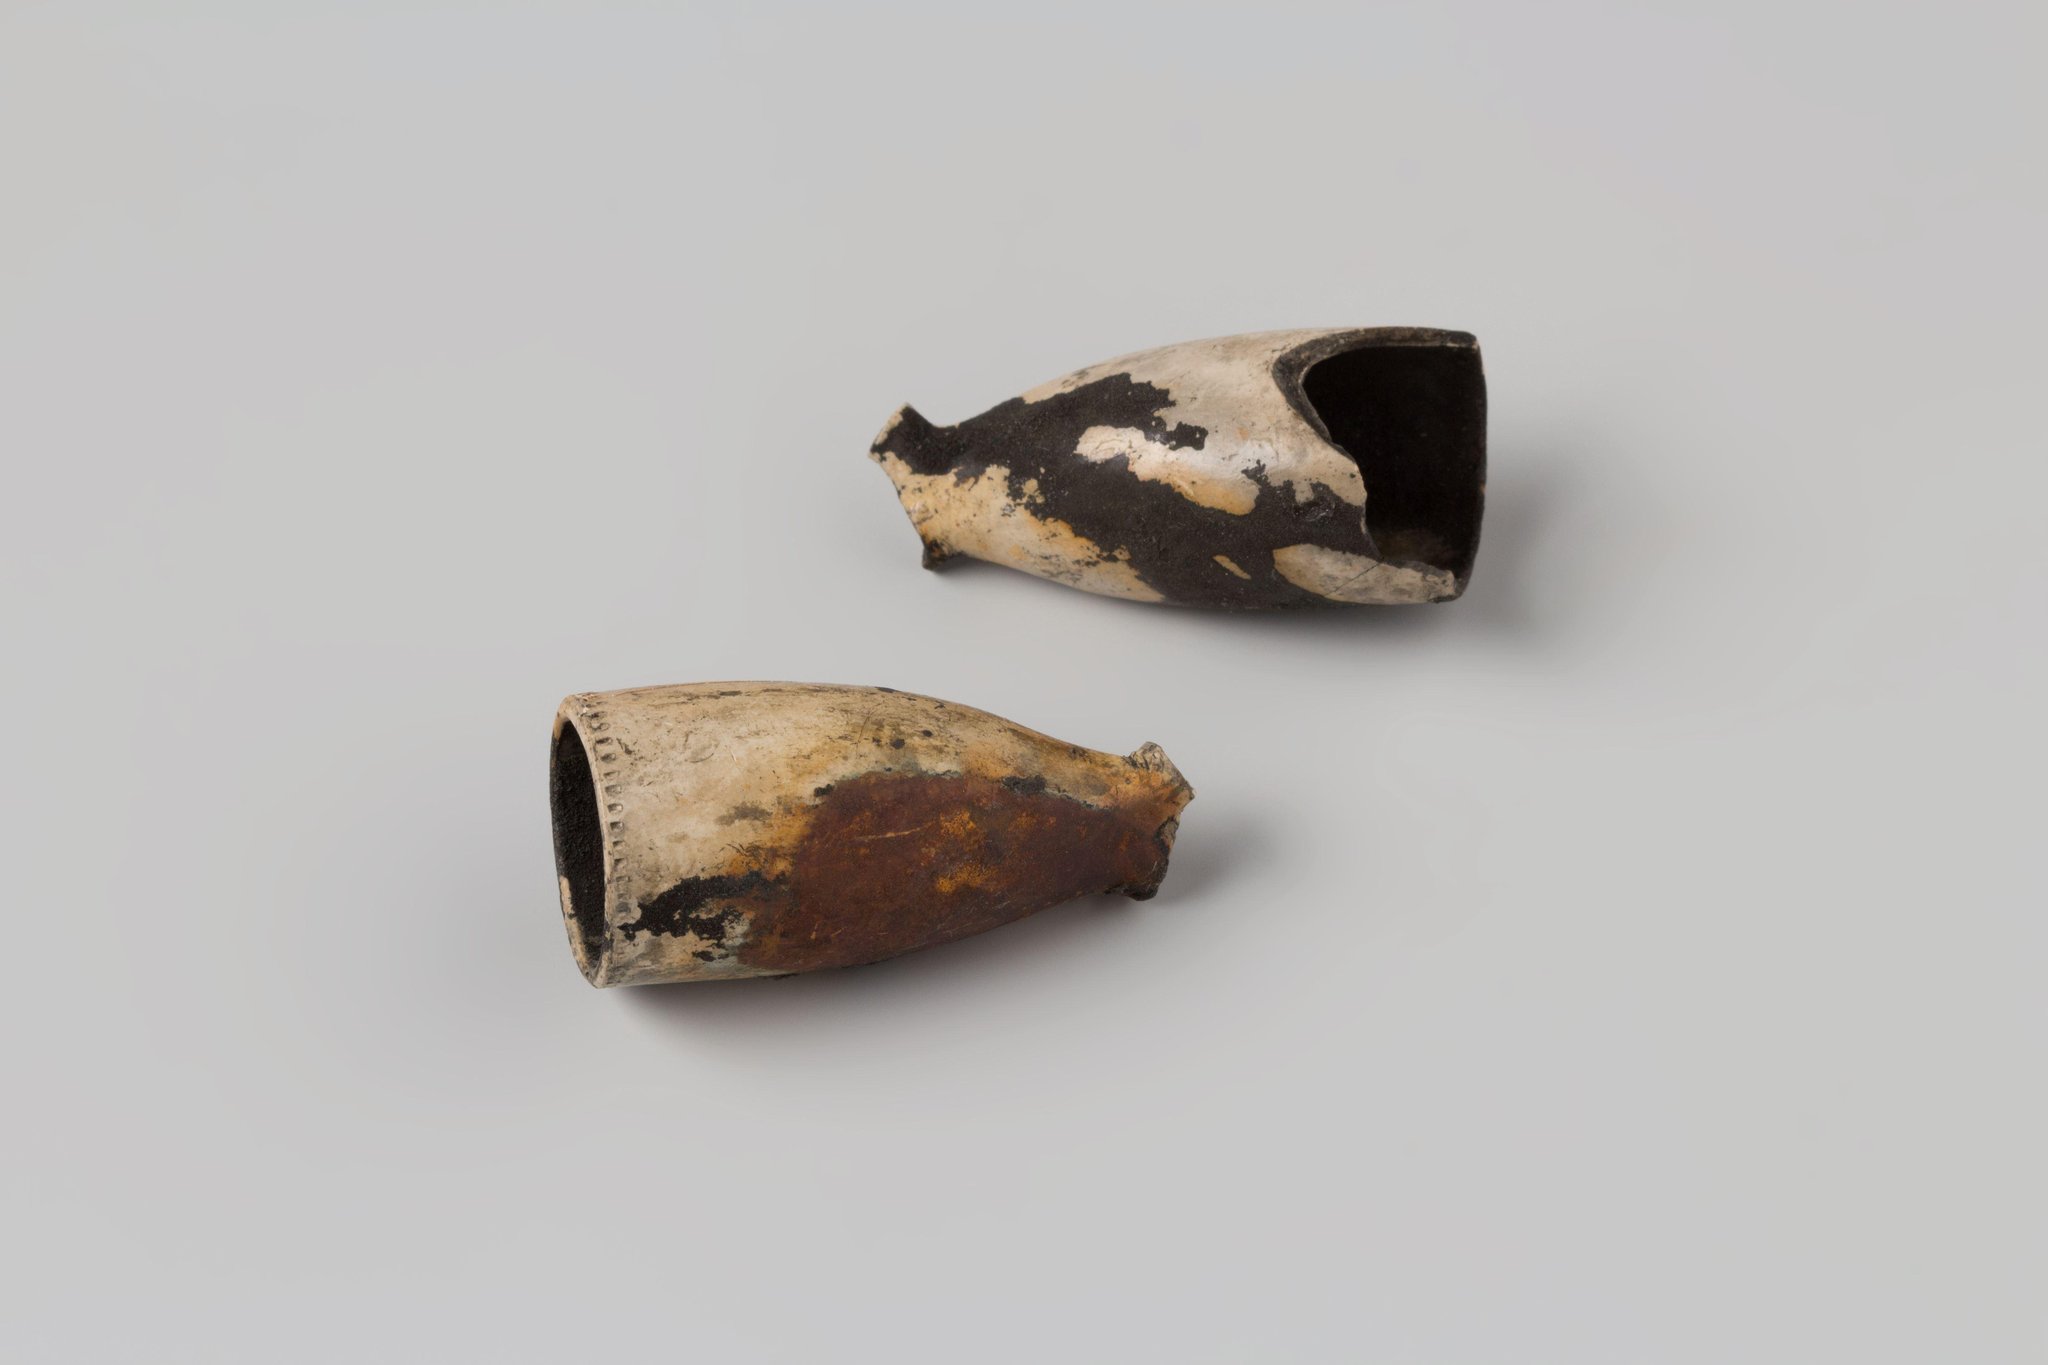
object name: pipe bowl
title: Pijpenkop uit het wrak van de Oost-Indiëvaarder Hollandia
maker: Anonymous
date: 1700-1743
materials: clay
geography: netherlands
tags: verenigde oostindische compagnie, hollandia (schip), annet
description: Pipe, bowl, heelmark: crowned 82; fragm, no hsm.